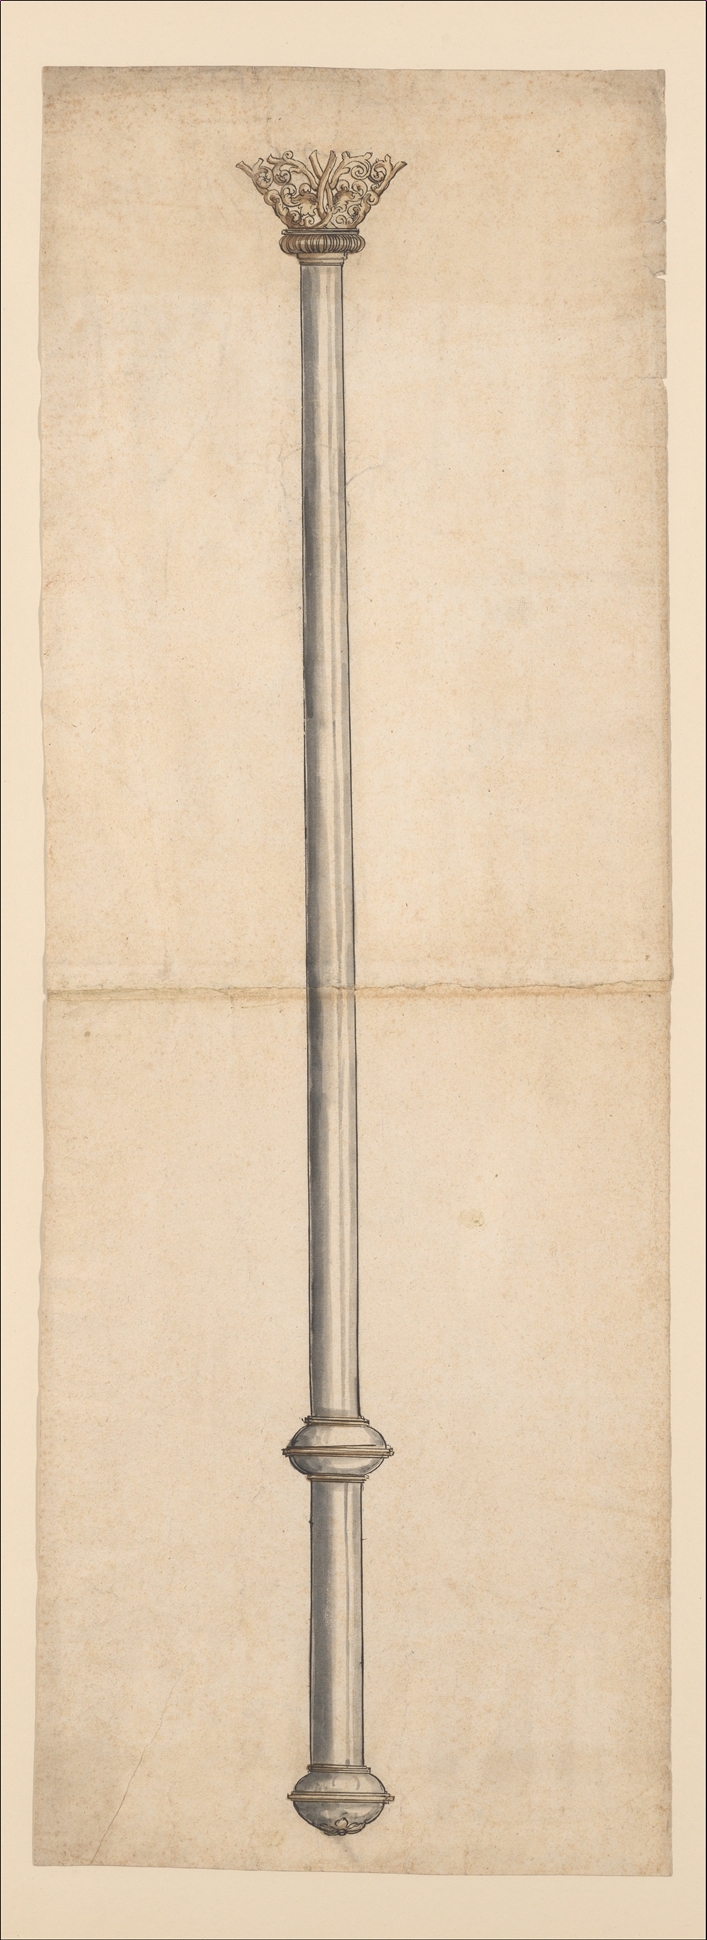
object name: drawing ornament architecture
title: Design for a Scepter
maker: anonymous, german, 16th century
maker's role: artist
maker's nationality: german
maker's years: 1500-1600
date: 1501-1600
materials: ink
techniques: brush, pen, wash